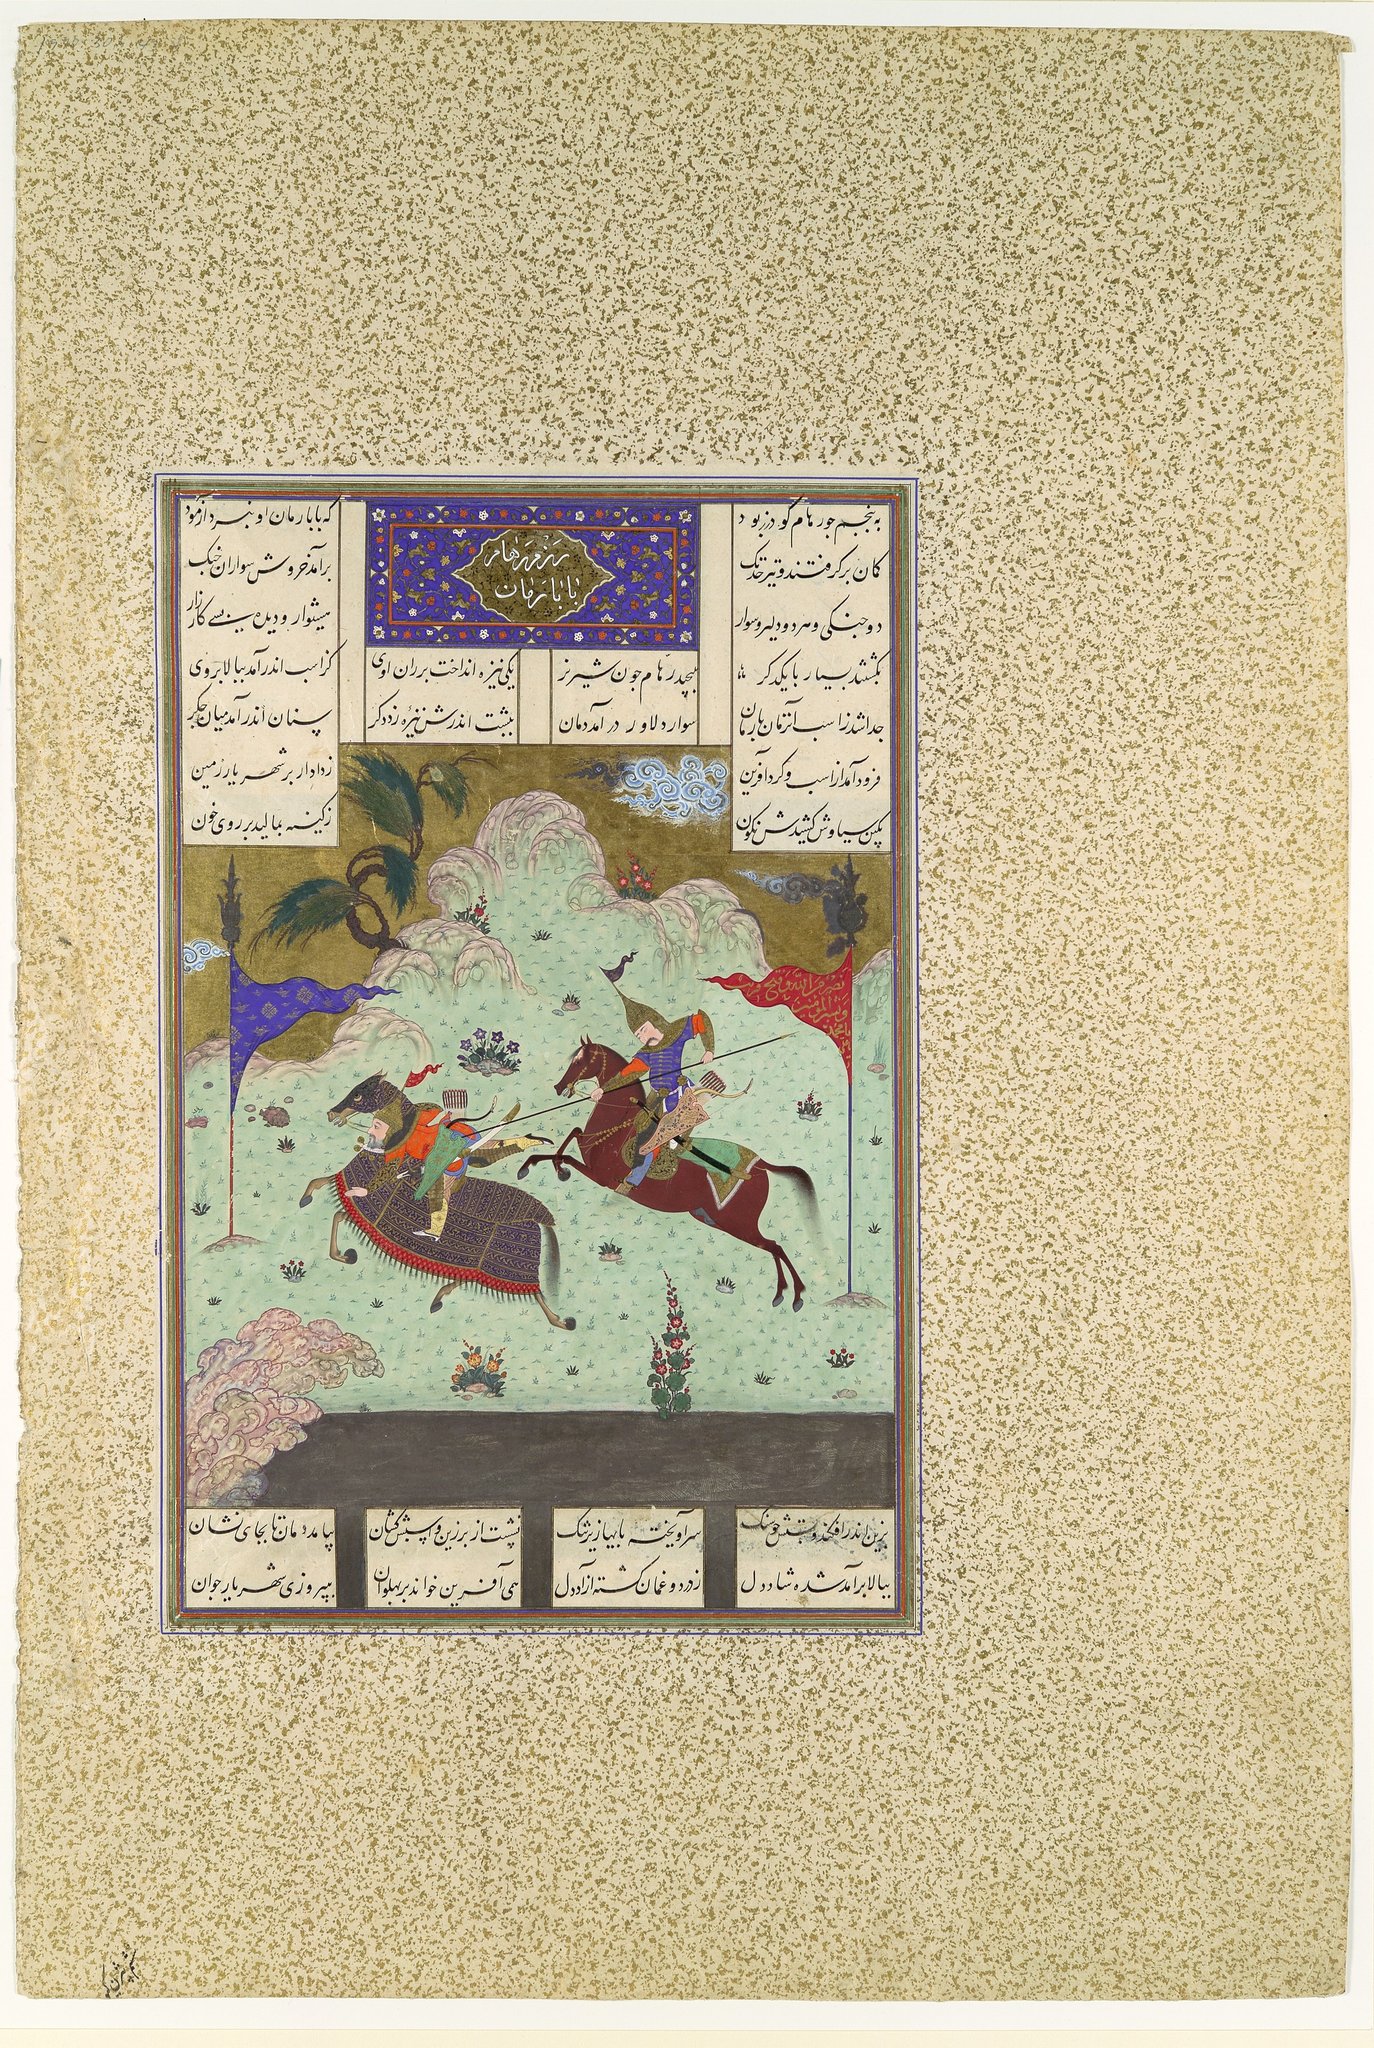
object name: folio from an illustrated manuscript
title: "The Fifth Joust of the Rooks: Ruhham Versus Barman", Folio 342v from the Shahnama (Book of Kings) of Shah Tahmasp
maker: abu'l qasim firdausi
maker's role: author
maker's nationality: iranian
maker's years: 935-1020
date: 1525-1530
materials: gold, ink, paper, silver, watercolor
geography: iran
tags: men,horses,flags